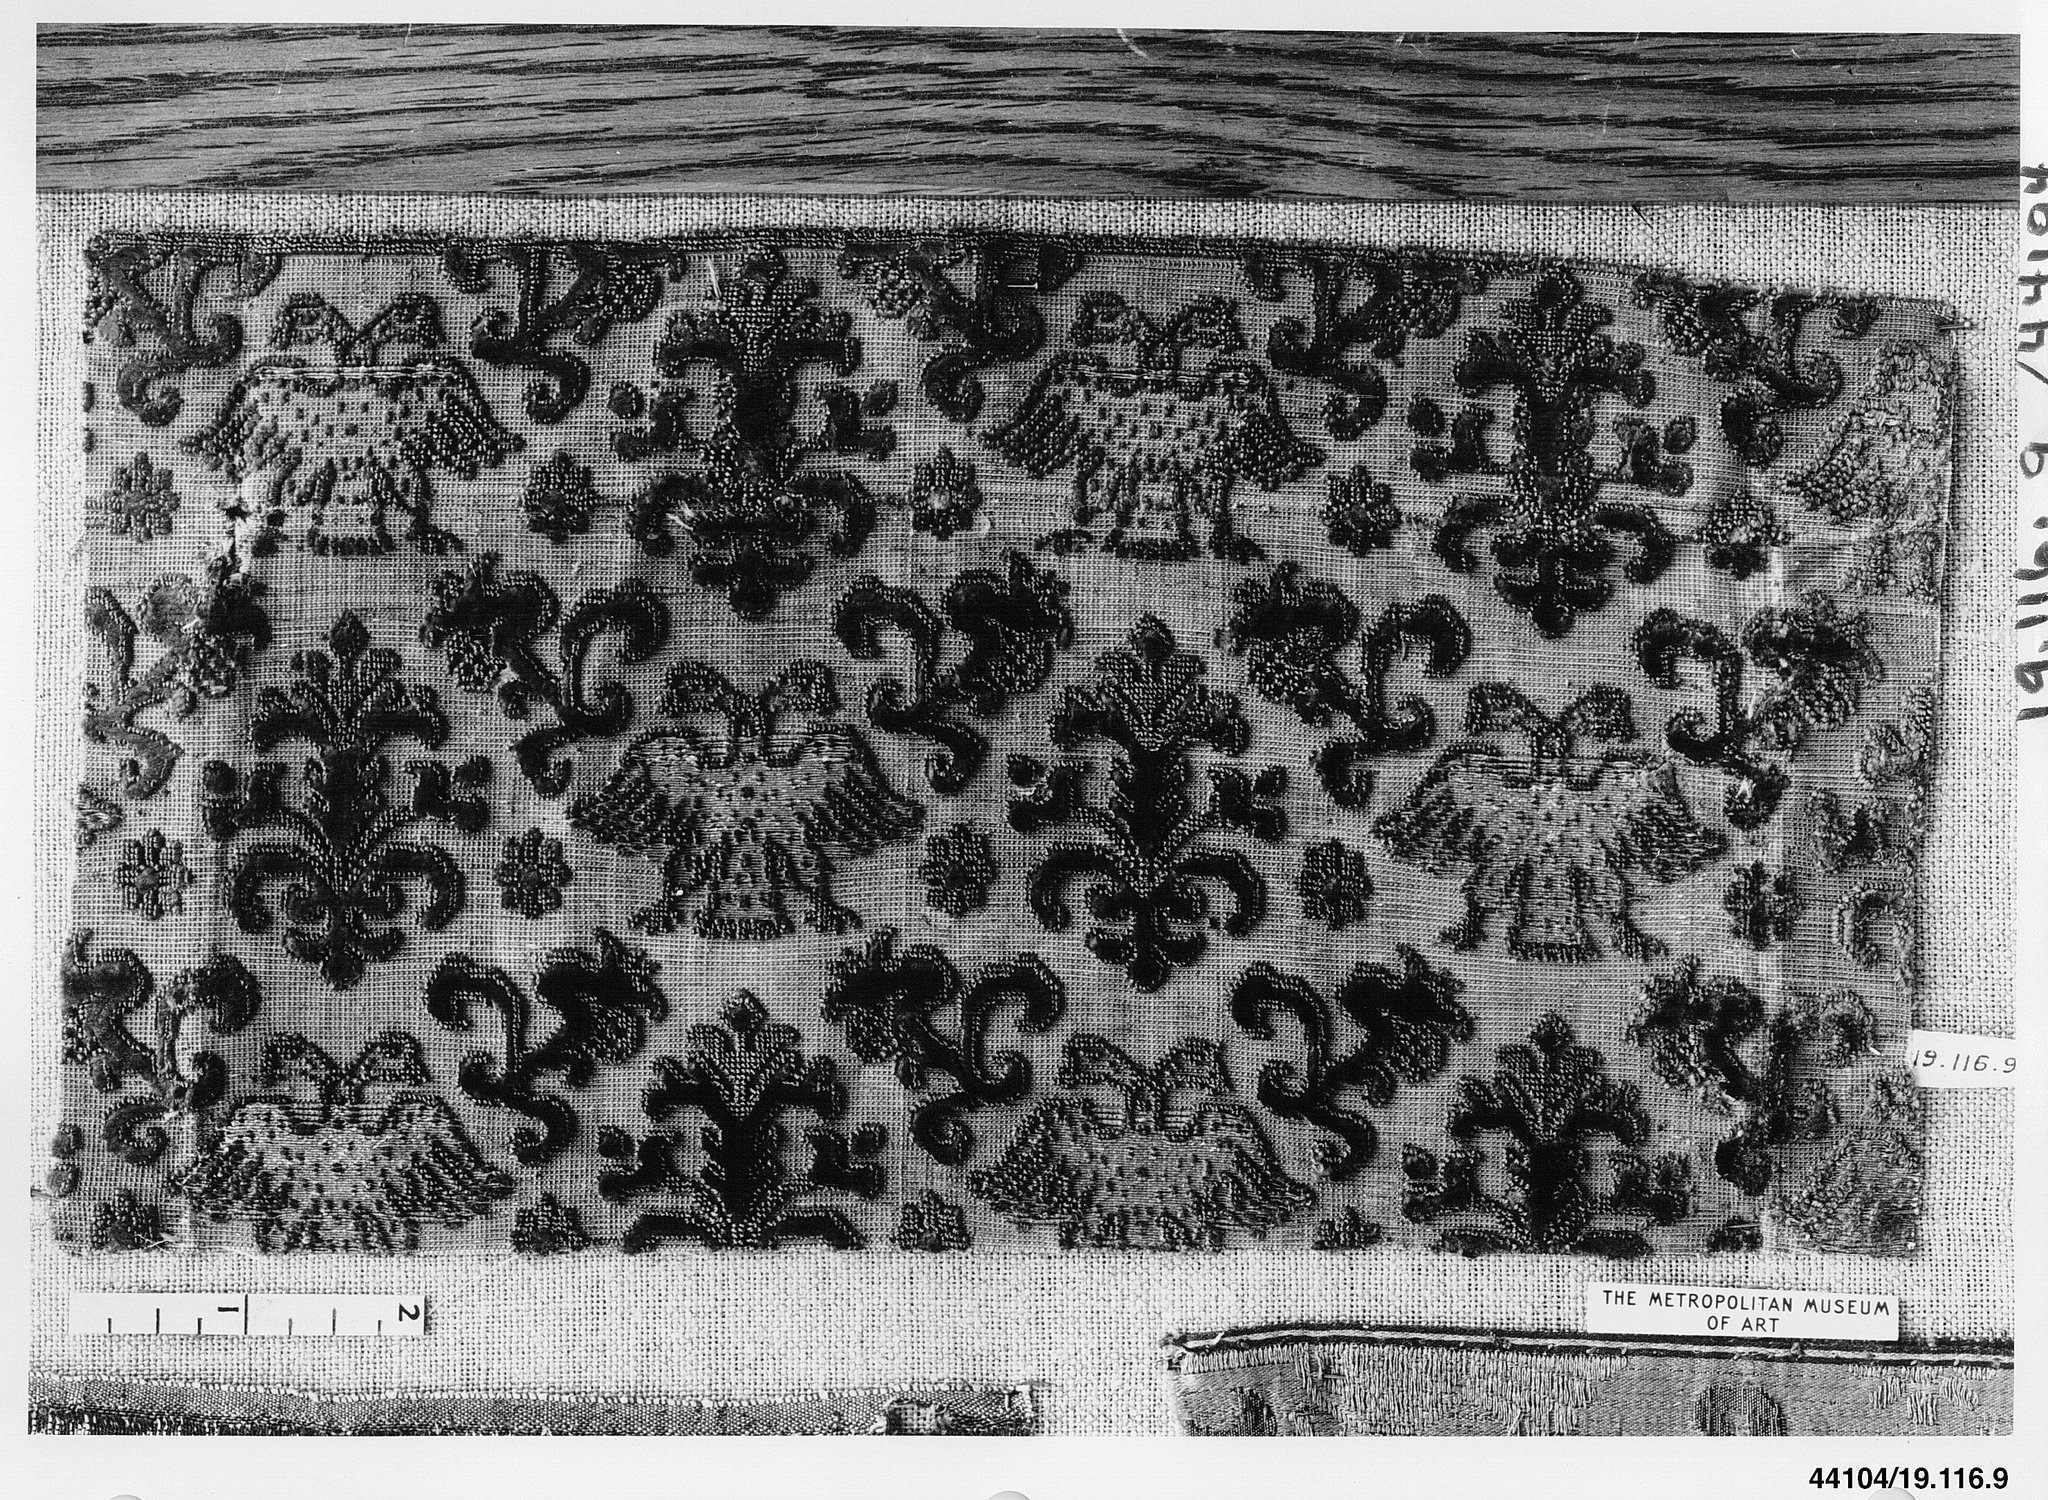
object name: piece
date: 1501-1700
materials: metal thread, silk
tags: eagles